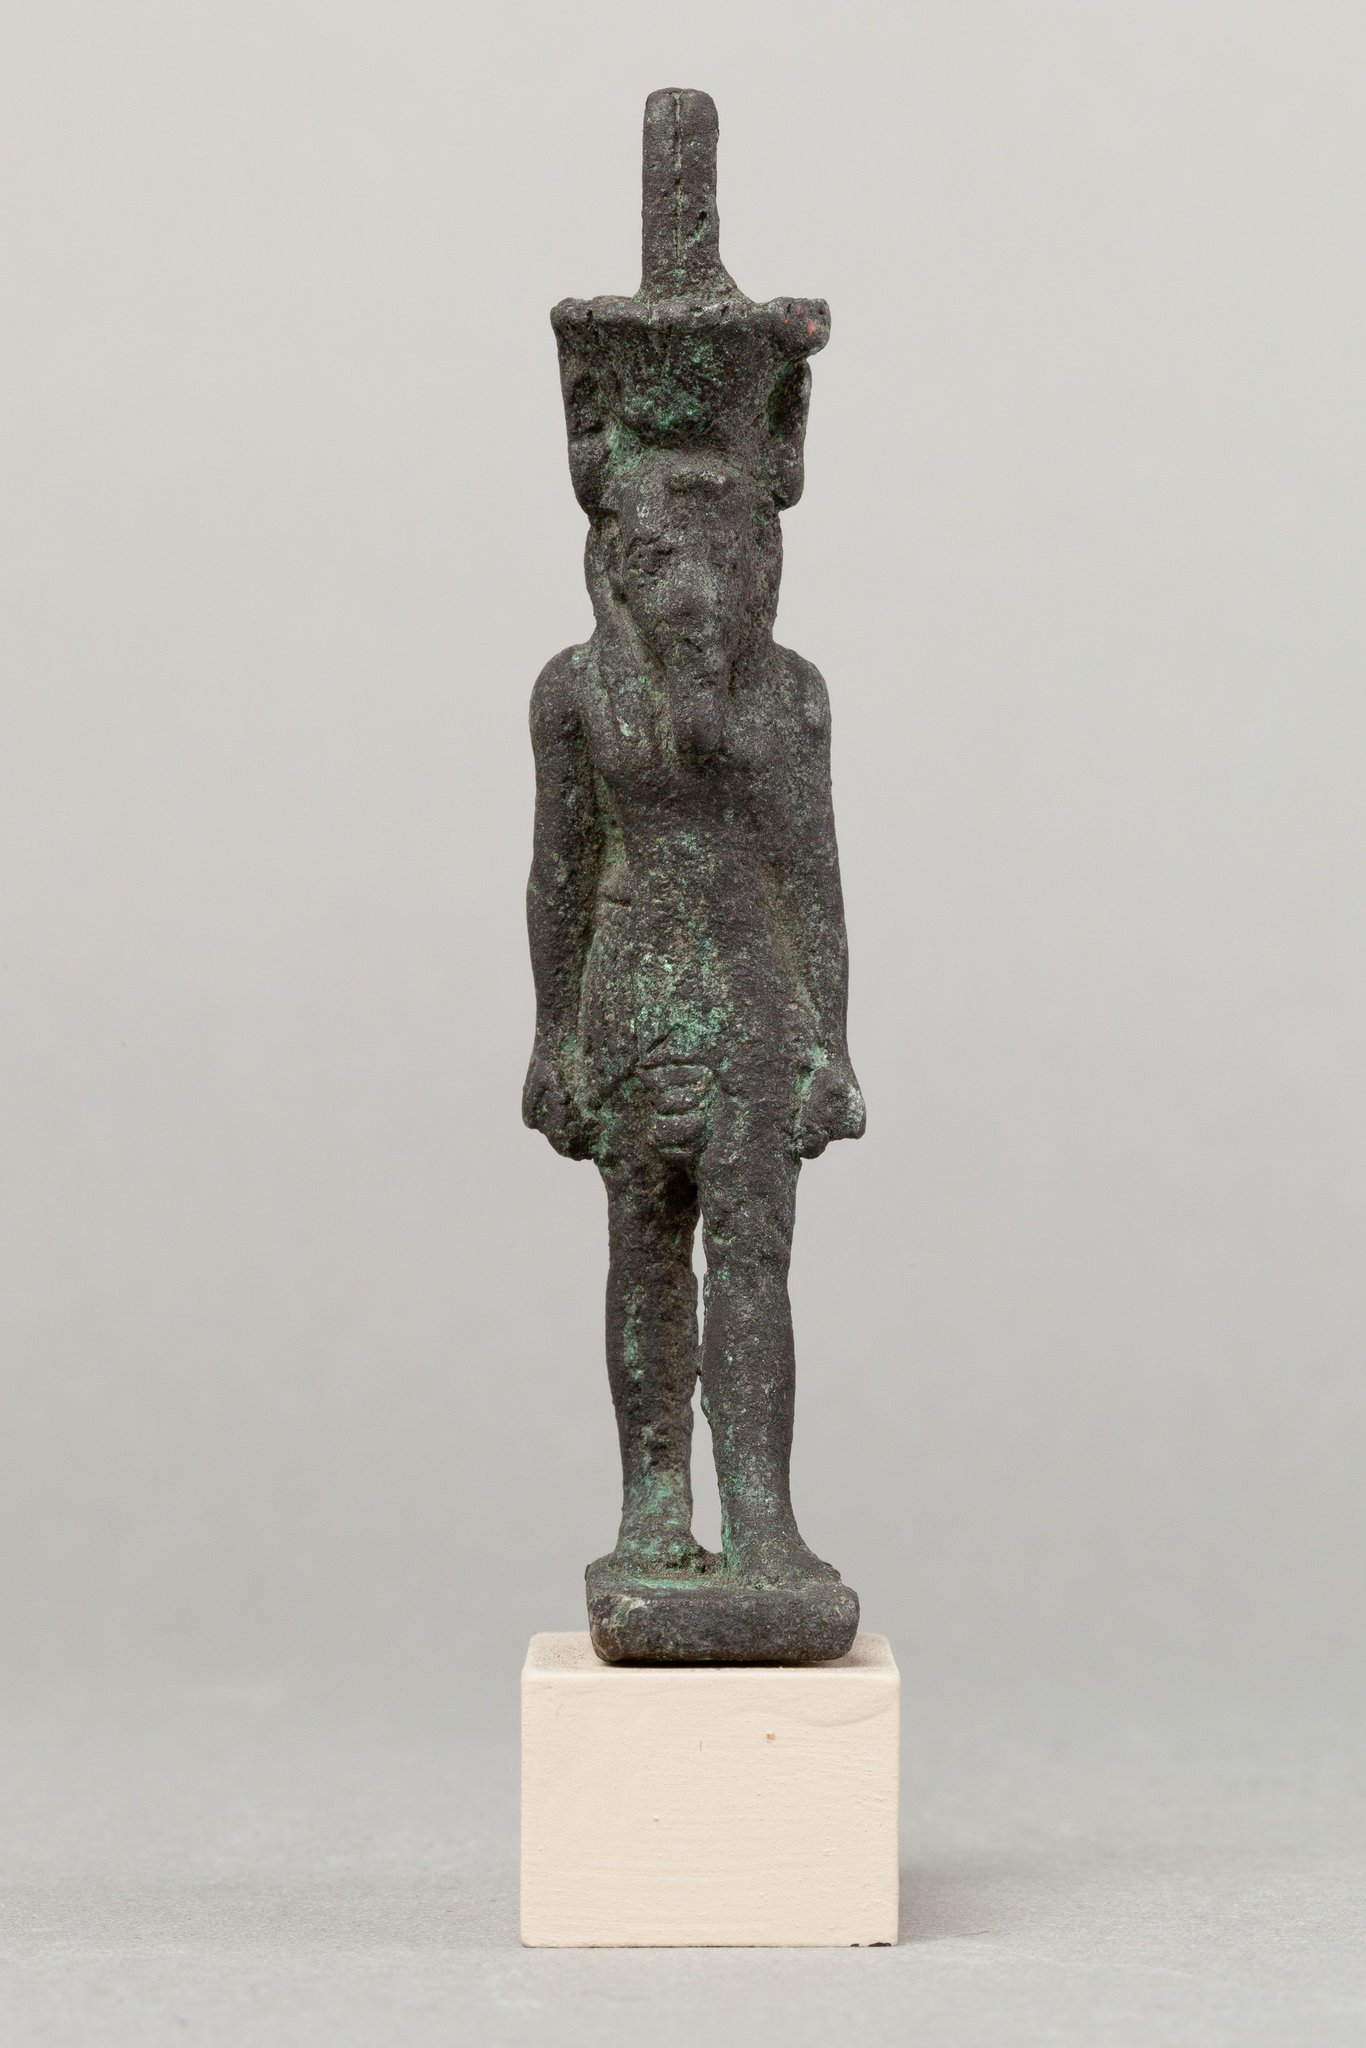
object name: statuette, nefertum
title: Nefertum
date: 664-630 BCE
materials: metal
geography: egypt